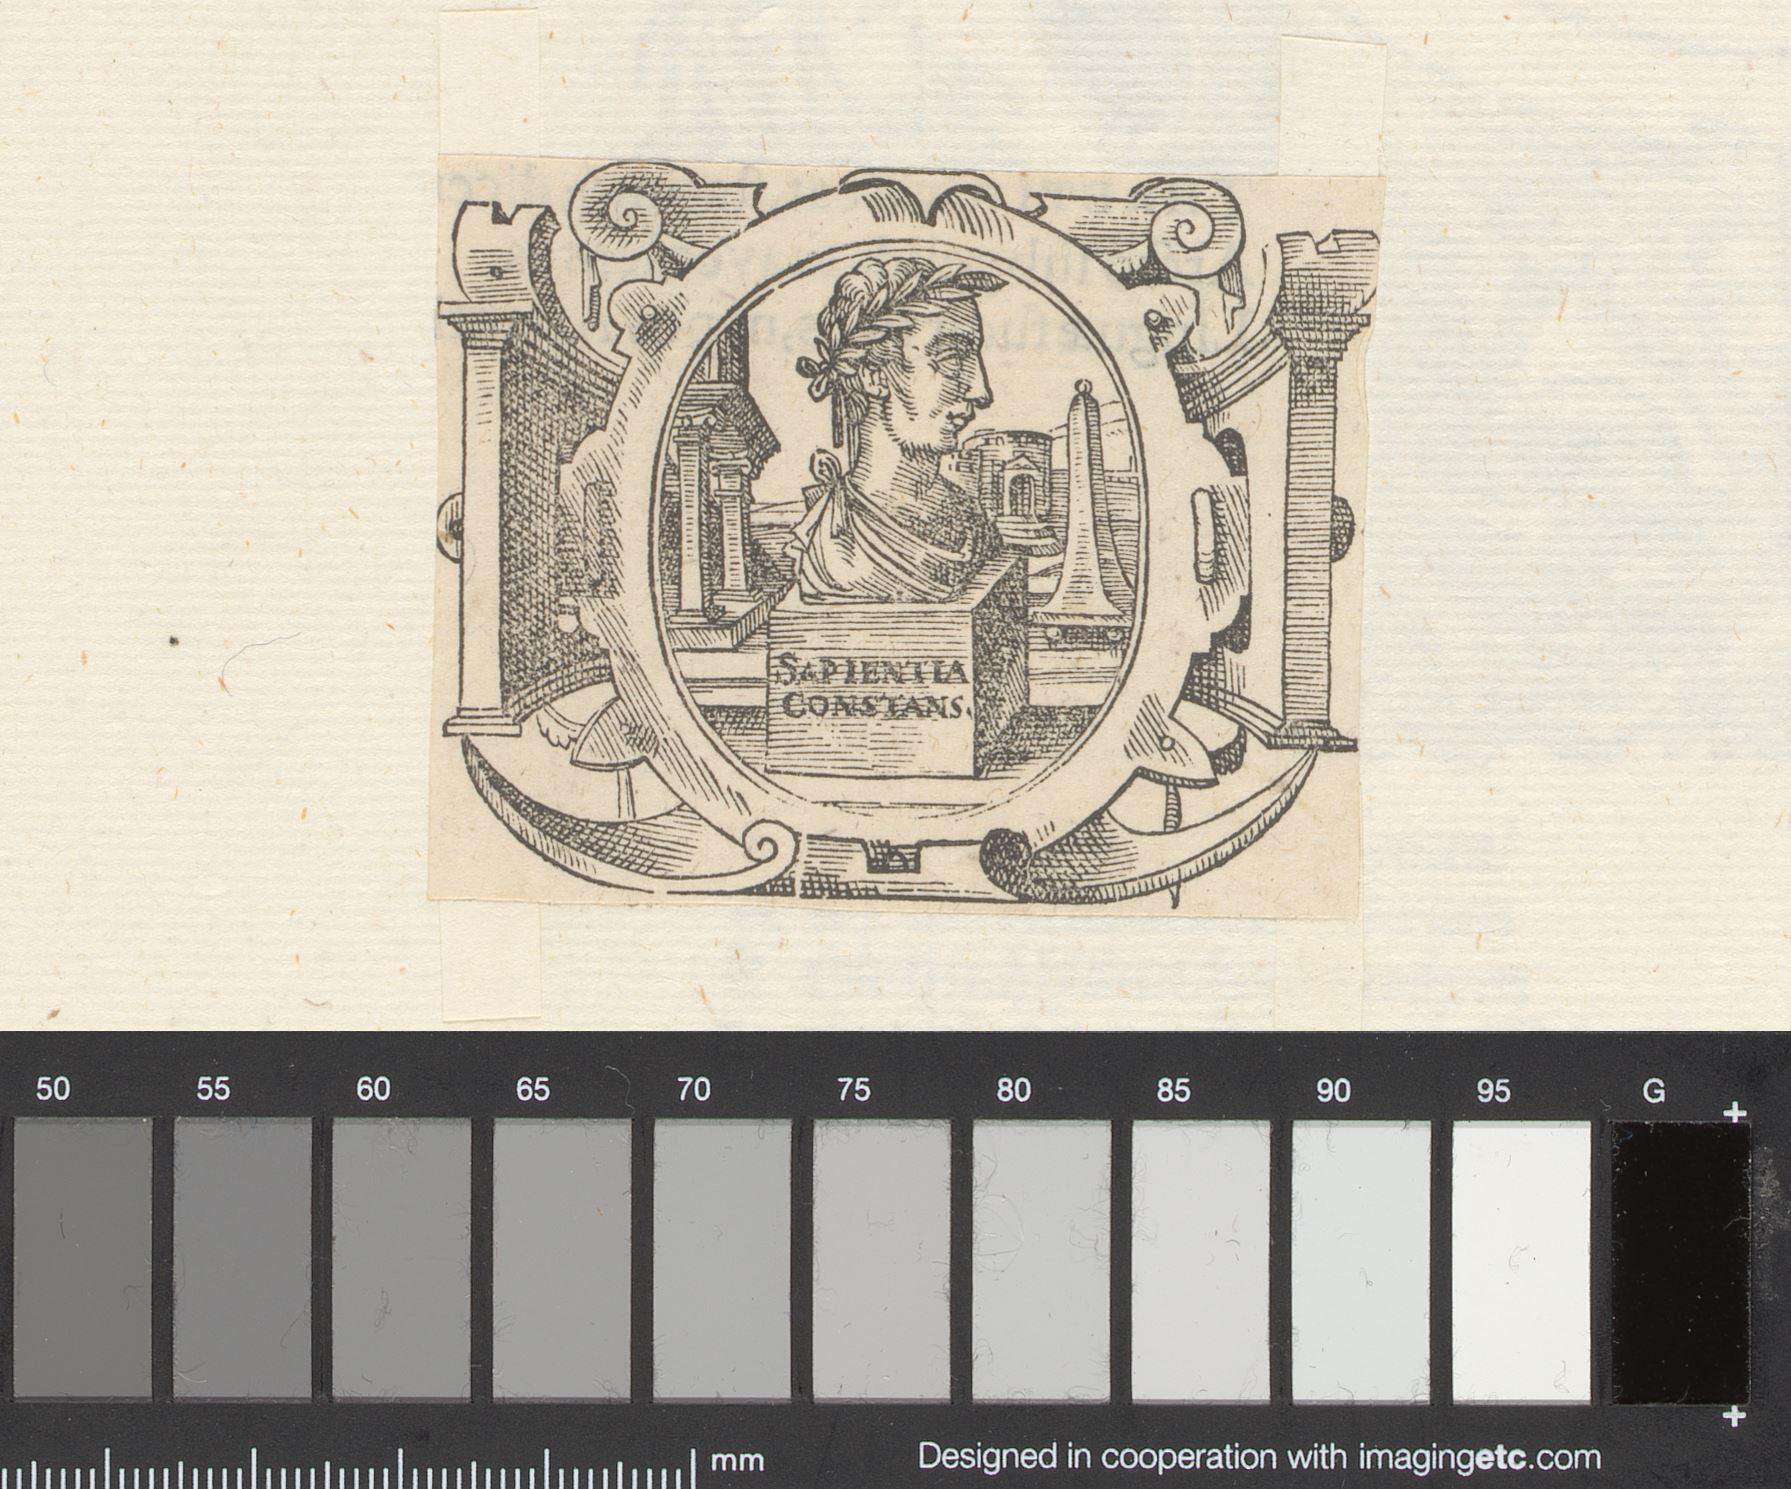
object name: album leaf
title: Portret van Bernhard Jobin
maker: Anonymous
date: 1549-1574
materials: paper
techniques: letterpress printing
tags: printer, bernhard jobin, publishing, publisher (+ portrait of scholar, scientist), historical persons, device (trade-mark of printer or publisher)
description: De prent is gebruikt als uitgeversmerk door Bernhard Jobin. Prent is gebruikt in: Toxites, Michael. Onomastica II: I. Philosophicum, Medicum, Synonymum ex variis vulgaribusq linguis. II. Theophrasti Paracelsi (...). Straatsburg: Bernhard Jobin, 1574